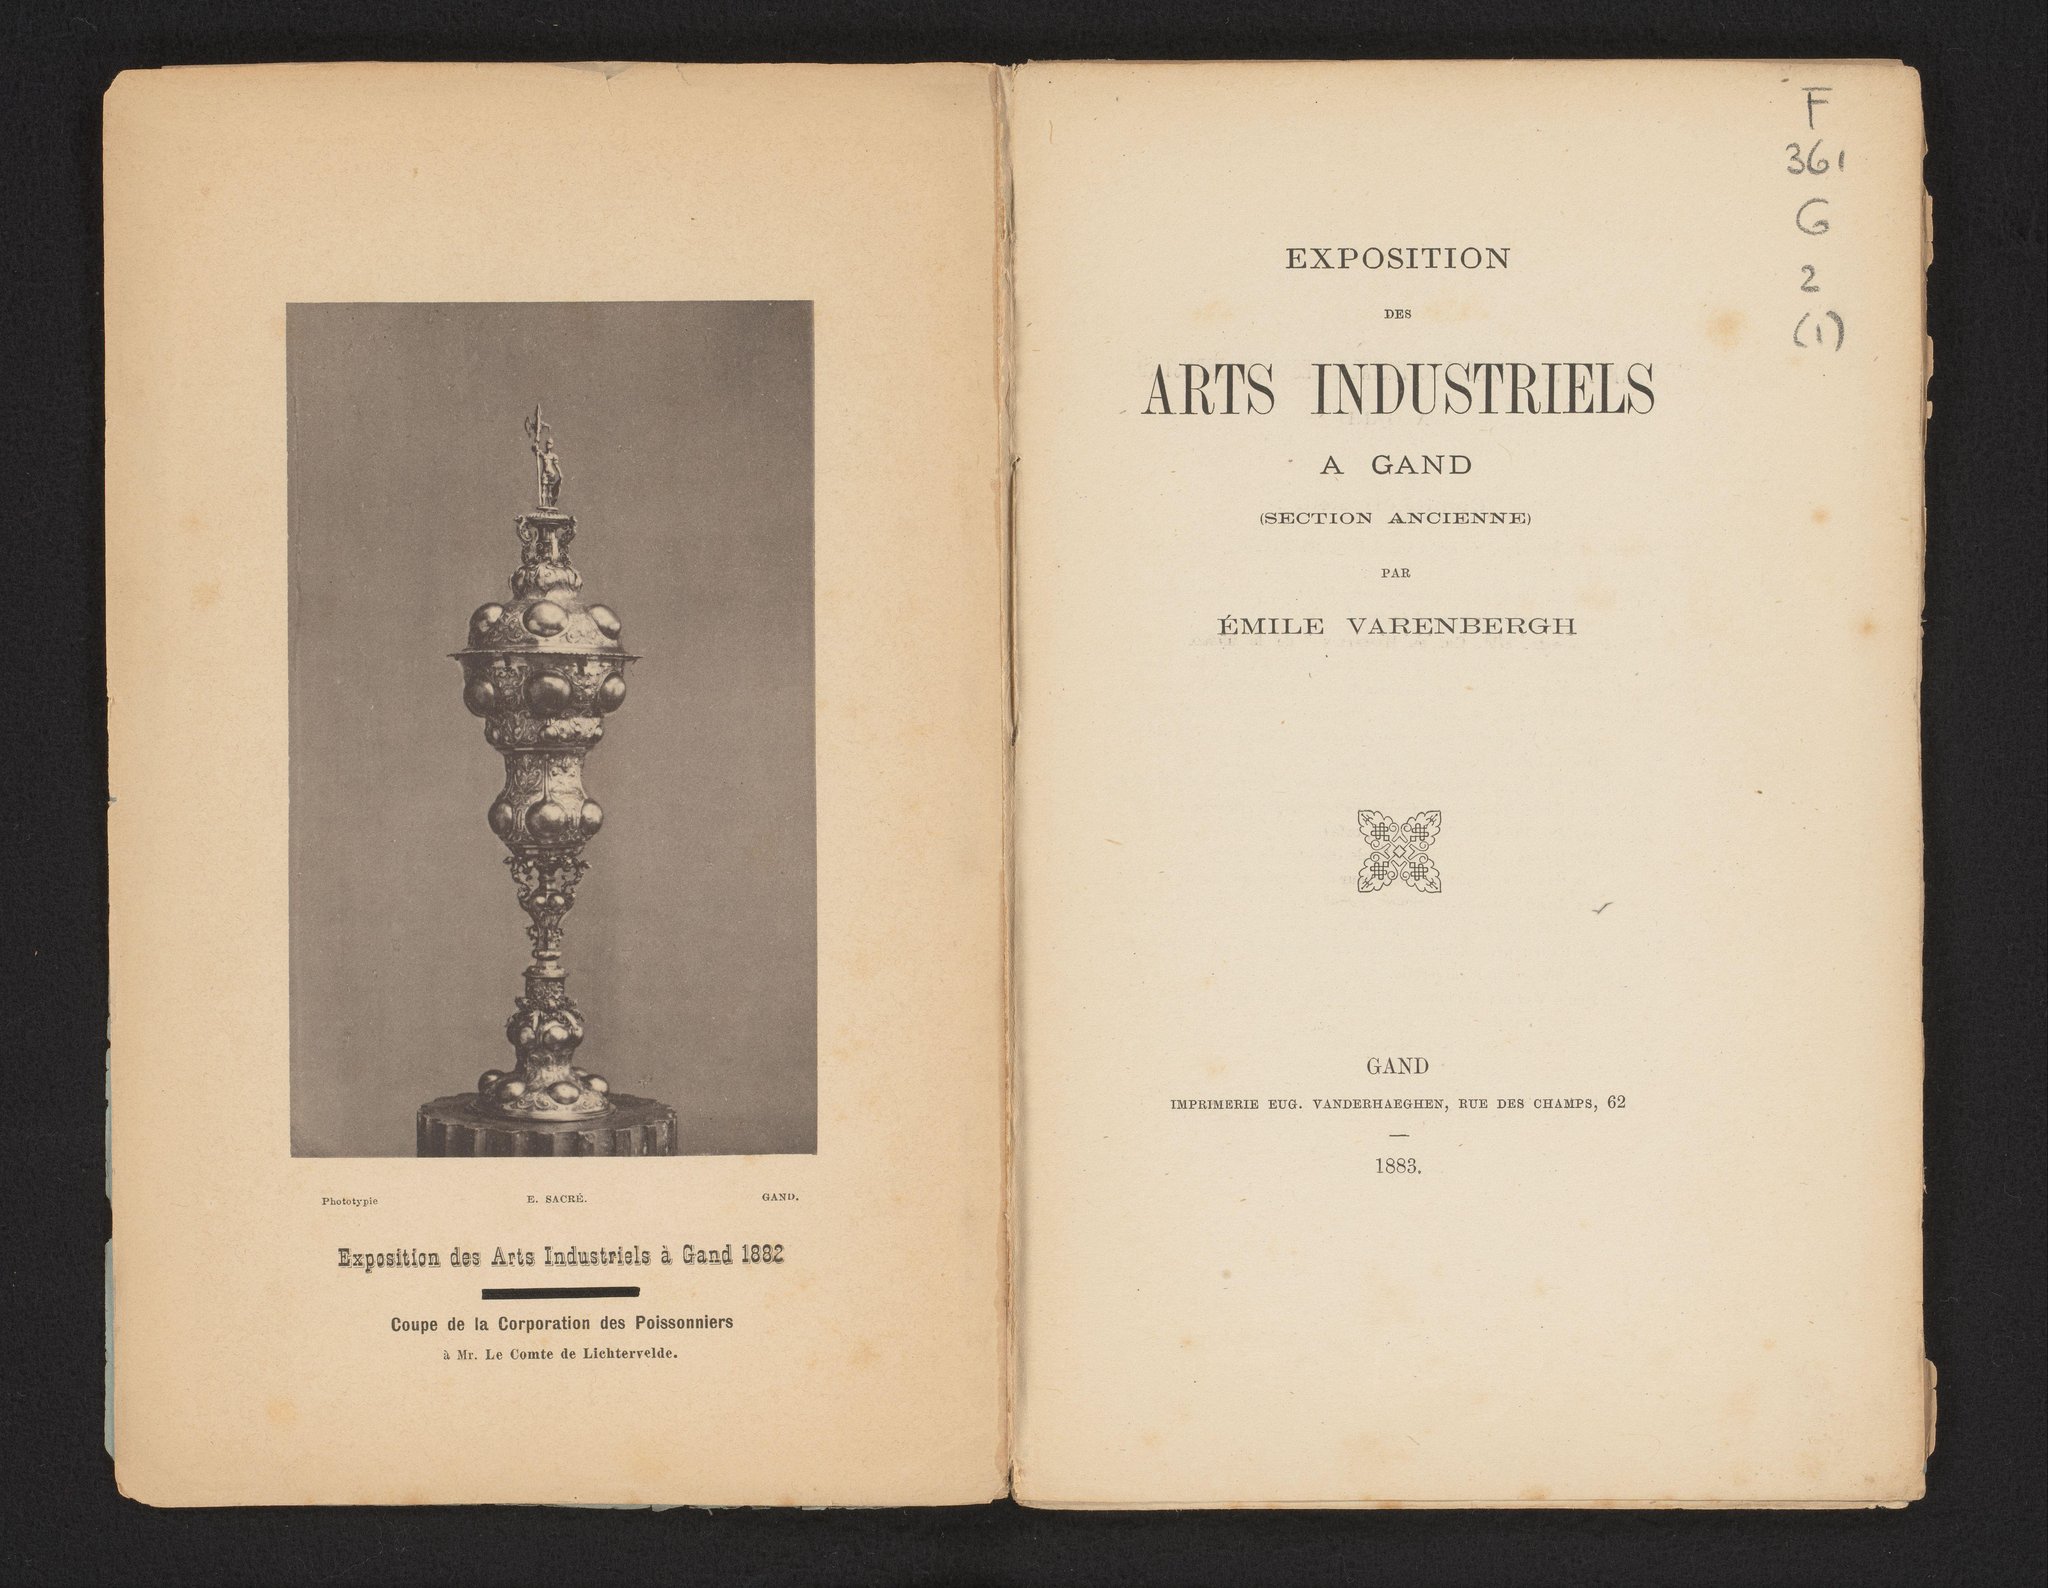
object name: book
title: Exposition des arts industriels à Gand (section ancienne)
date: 1883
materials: paper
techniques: photograph, printing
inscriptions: annotation: ‘SEPT/ 1992’